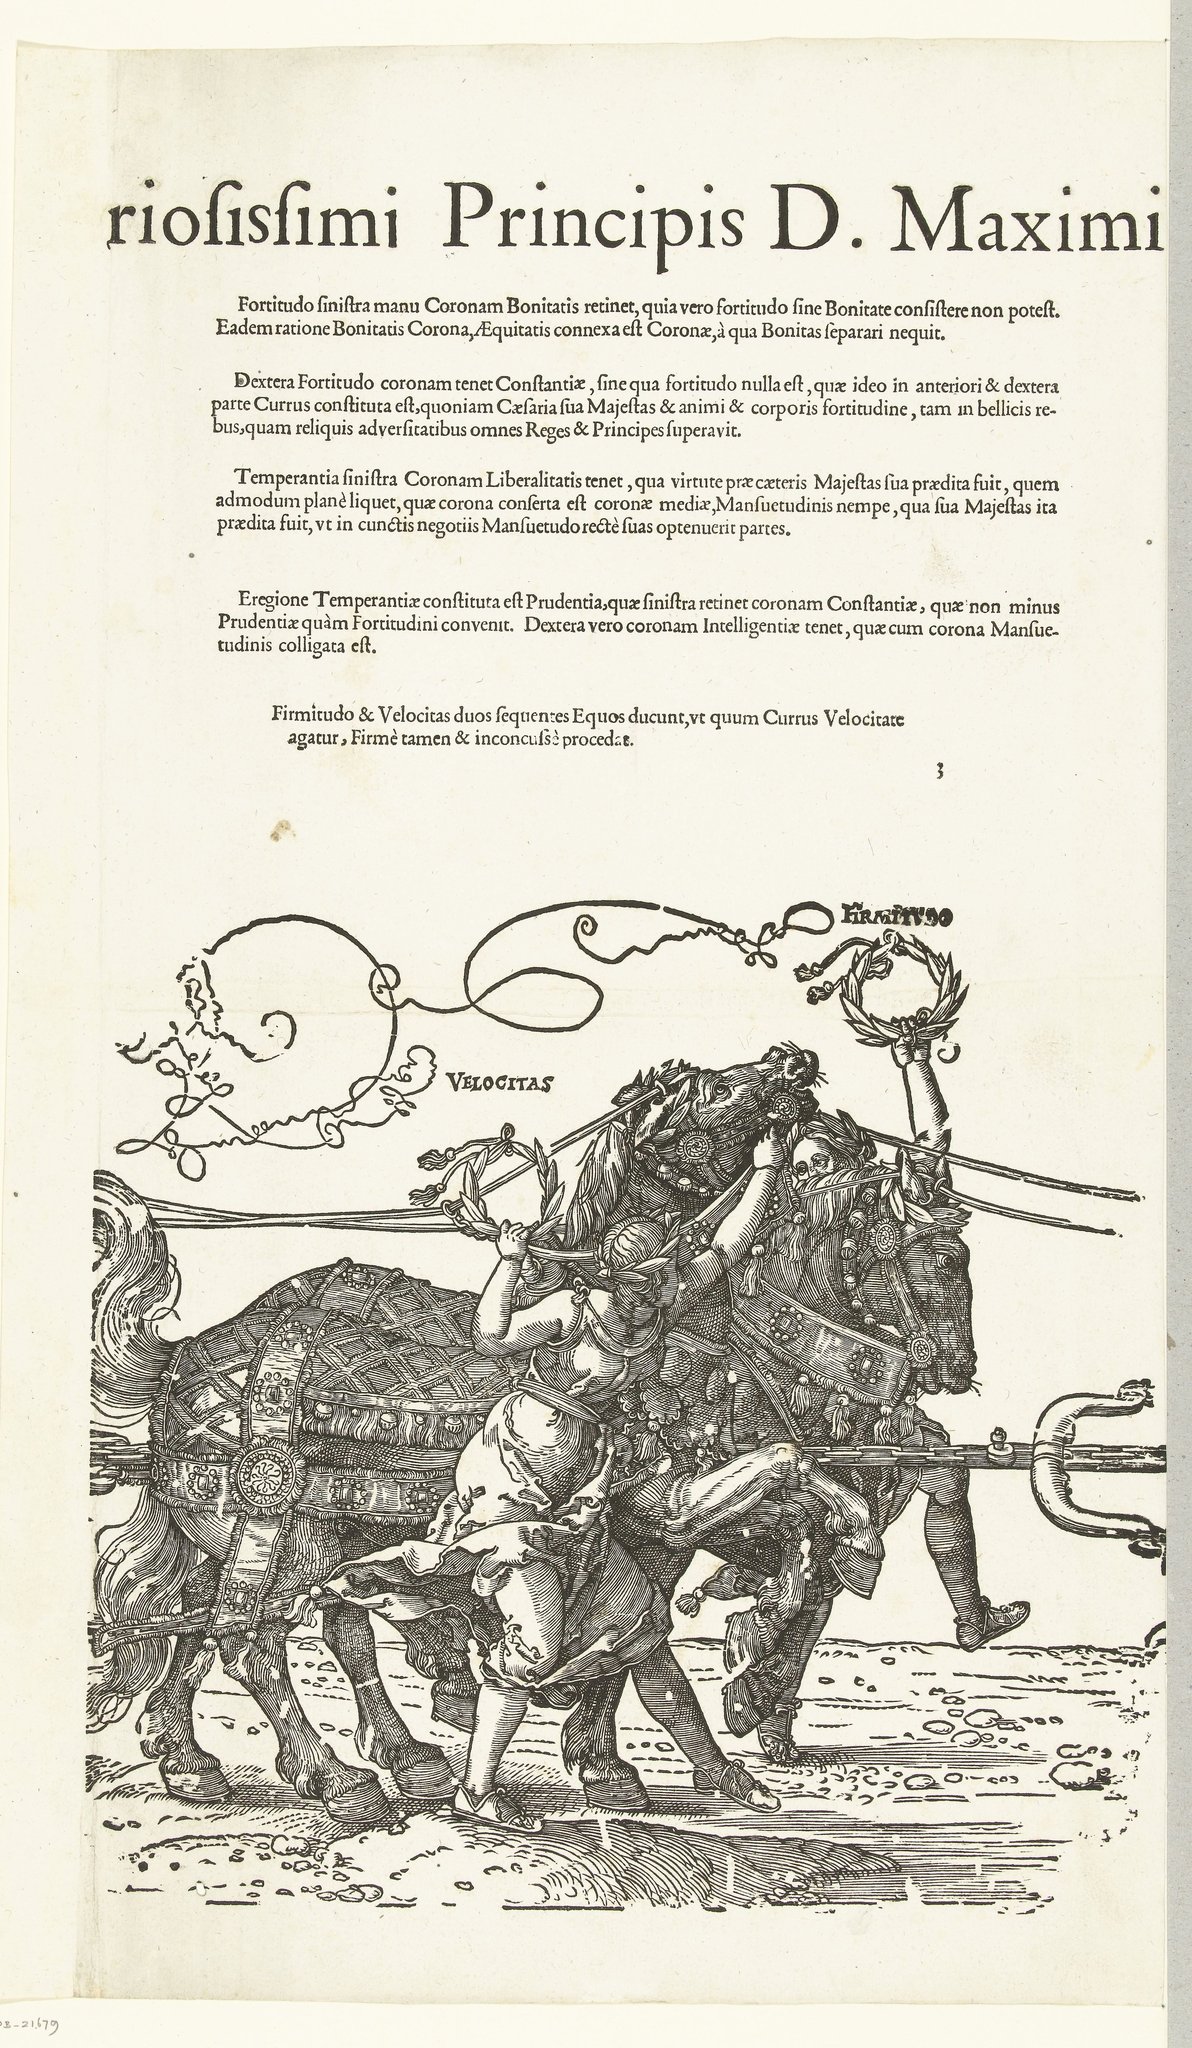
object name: print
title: Triomfwagen van keizer Maximiliaan I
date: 1527-1529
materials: paper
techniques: letterpress printing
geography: amsterdam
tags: maximilian i (holy roman emperor), chariot, triumphal car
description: De grote triomfwagen ter ere van keizer Maximiliaan I bij zijn overlijden op 12 januari 1519. Vijfde blad met het derde span paarden met Velocitas en Firmitudo.